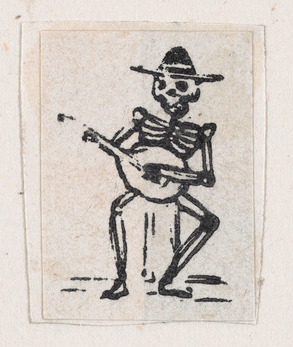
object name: print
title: Skeleton playing the guitar, from a broadside entitled 'De este famoso hipodromo en la pista, no faltara ni un solo periodista', published by Antonio Vanegas Arroyo.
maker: josé guadalupe posada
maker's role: artist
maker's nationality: mexican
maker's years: 1852-1913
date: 1889-1895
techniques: lithography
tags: skeletons,guitars